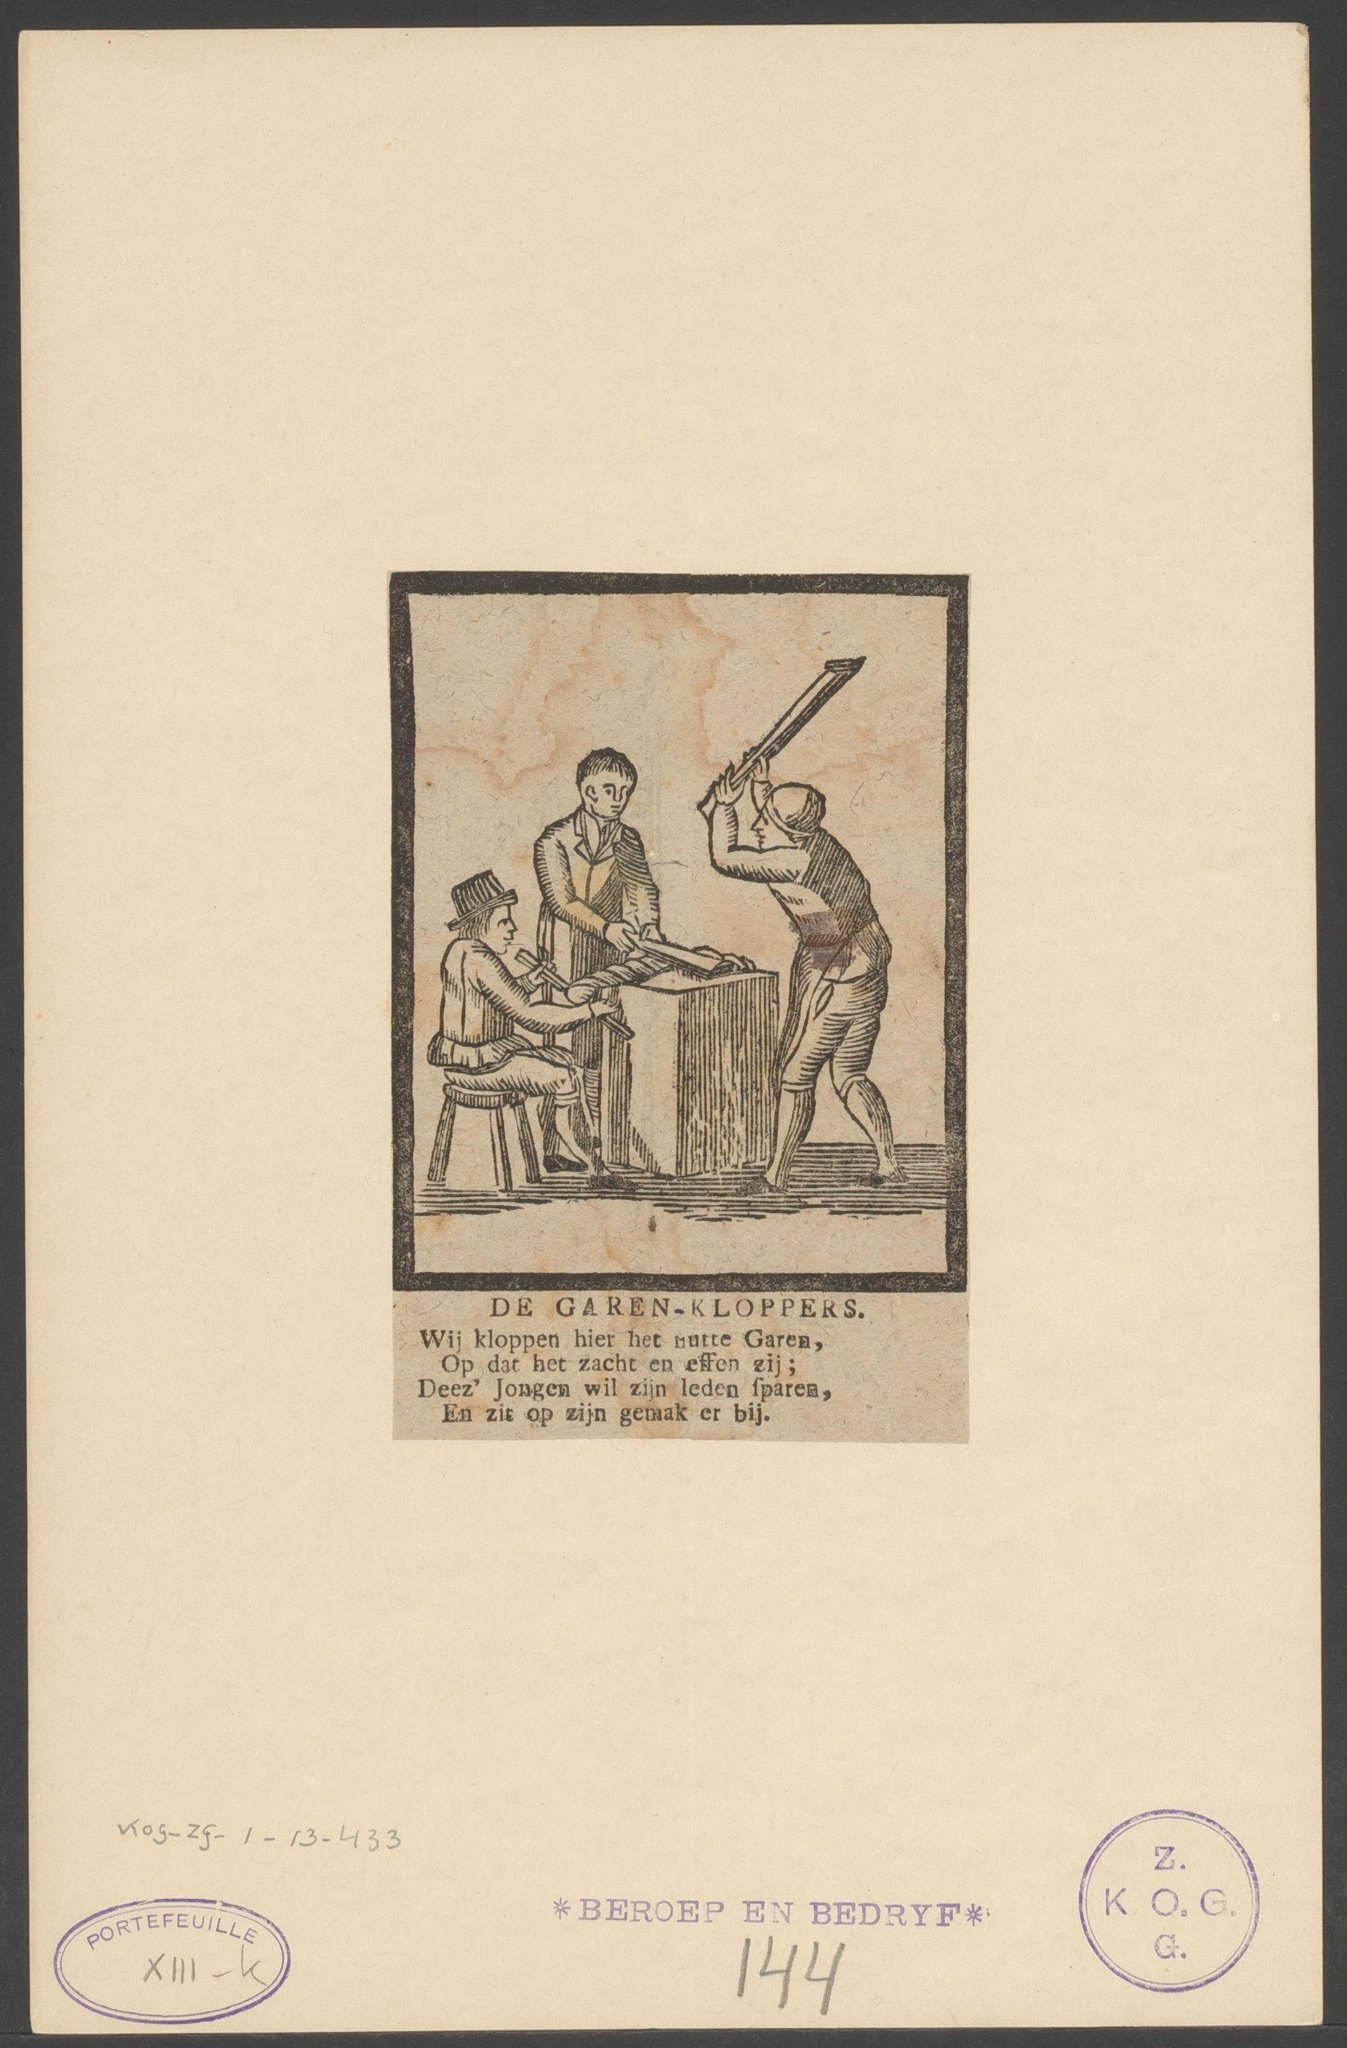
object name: print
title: Garentwijder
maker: alexander cranendoncq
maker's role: draughtsman, print maker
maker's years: 1799-1869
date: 1809-1869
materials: paper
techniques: letterpress printing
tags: handicrafts, craftsman at work, materials ~ textile industry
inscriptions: stamp, stamp, collector's mark: Lugt 1641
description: Bij het twijnen is het in elkaar draaien van vezels waardoor garen ontstaat. Onderaan een vierregelig vers. Onderwerpsrubrieken binnen de Atlas Zeden en Gewoonten: Handel, Nijverheid en verkeer, Beroep en bedrijf, Mannelijk, Lakenindustrie en aanverwante vakken.